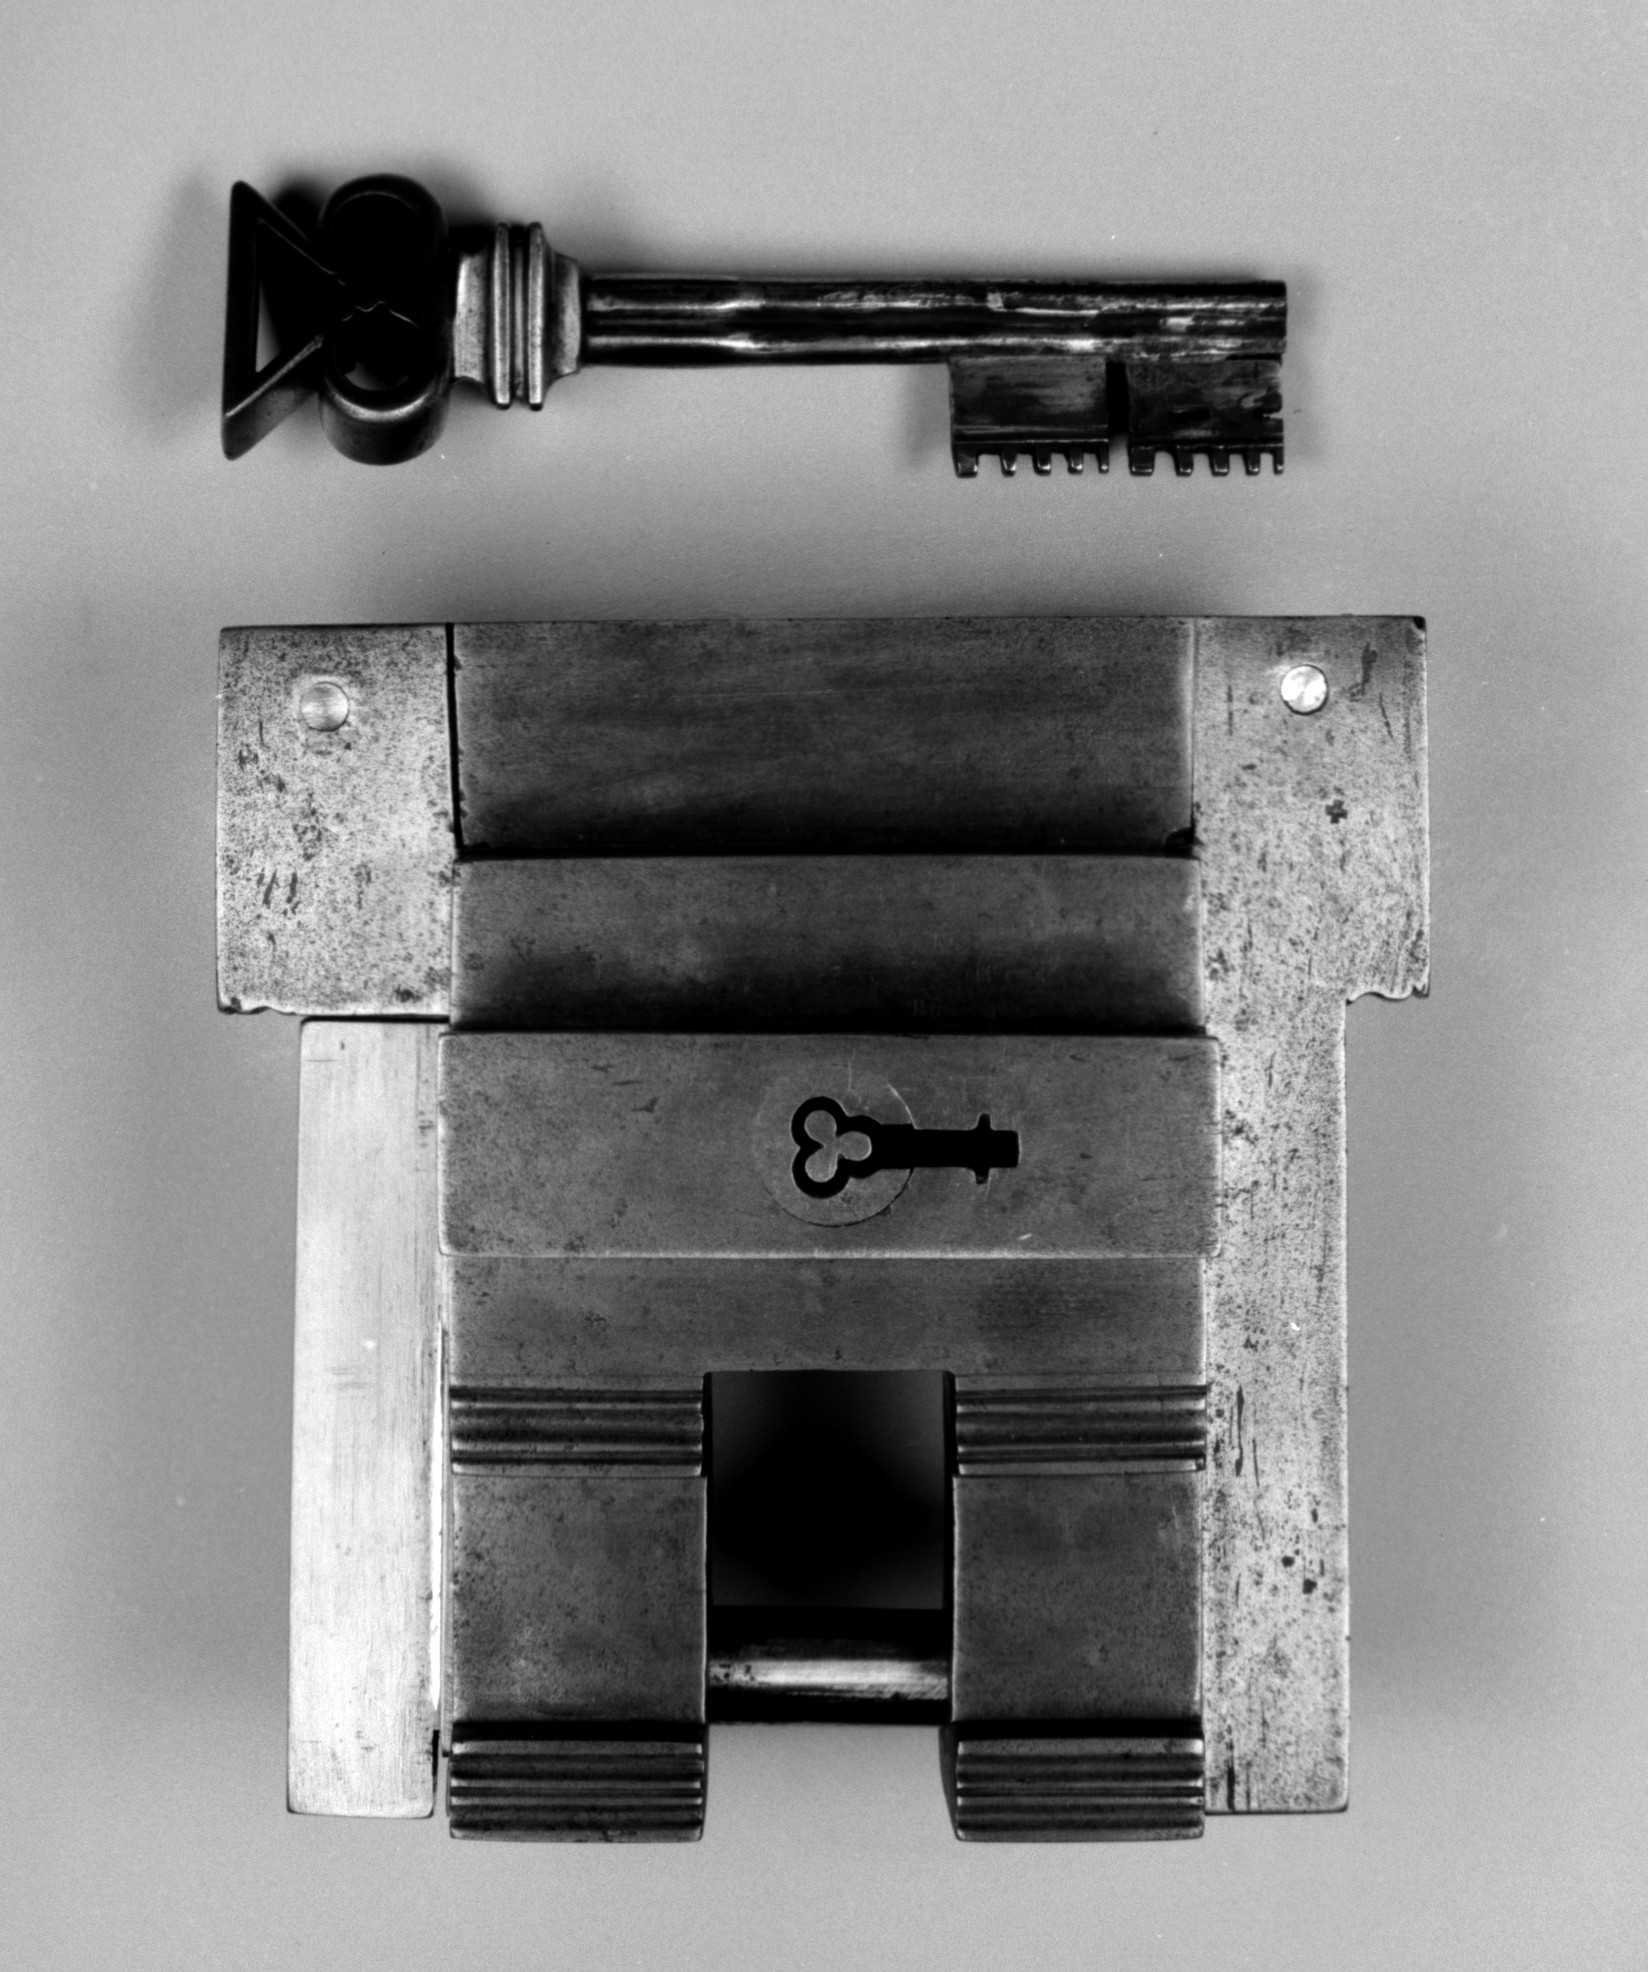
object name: padlock with key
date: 1567-1633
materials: steel